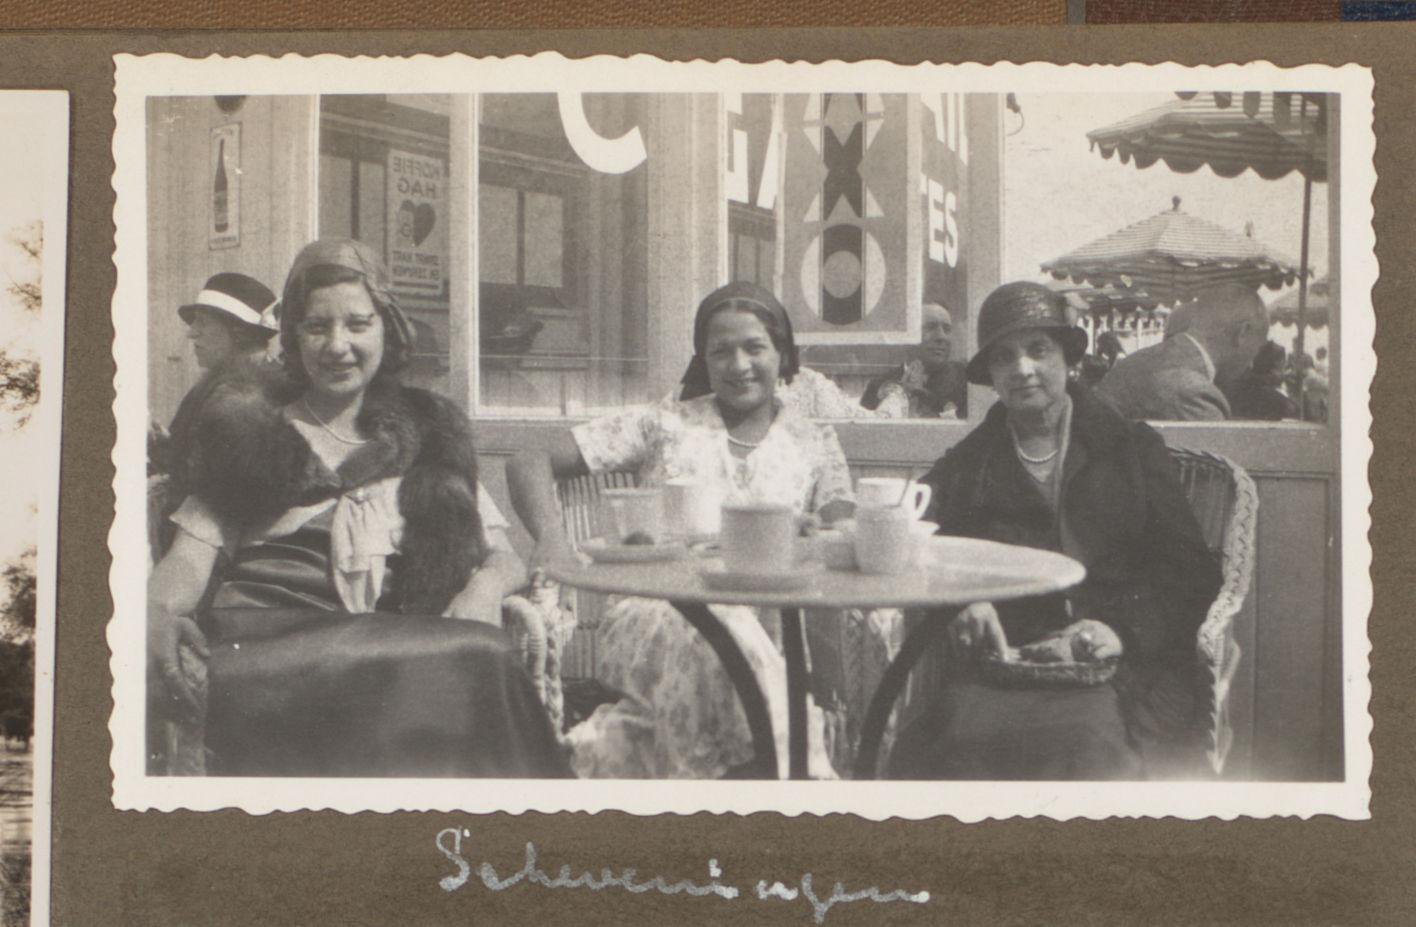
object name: album leaf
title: Corry Goelst, Wilhelmina van Zijll de Jong en Henriëtte Wassink op een terras in Scheveningen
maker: Anonymous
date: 1932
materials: paper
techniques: gelatin silver print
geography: scheveningen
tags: batavia, the hague, henriëtte wassink, wilhelmina van zijll de jong, historical persons - bb - woman, pavement, terrace in front of inn or restaurant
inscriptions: inscription: ‘Scheveningen’